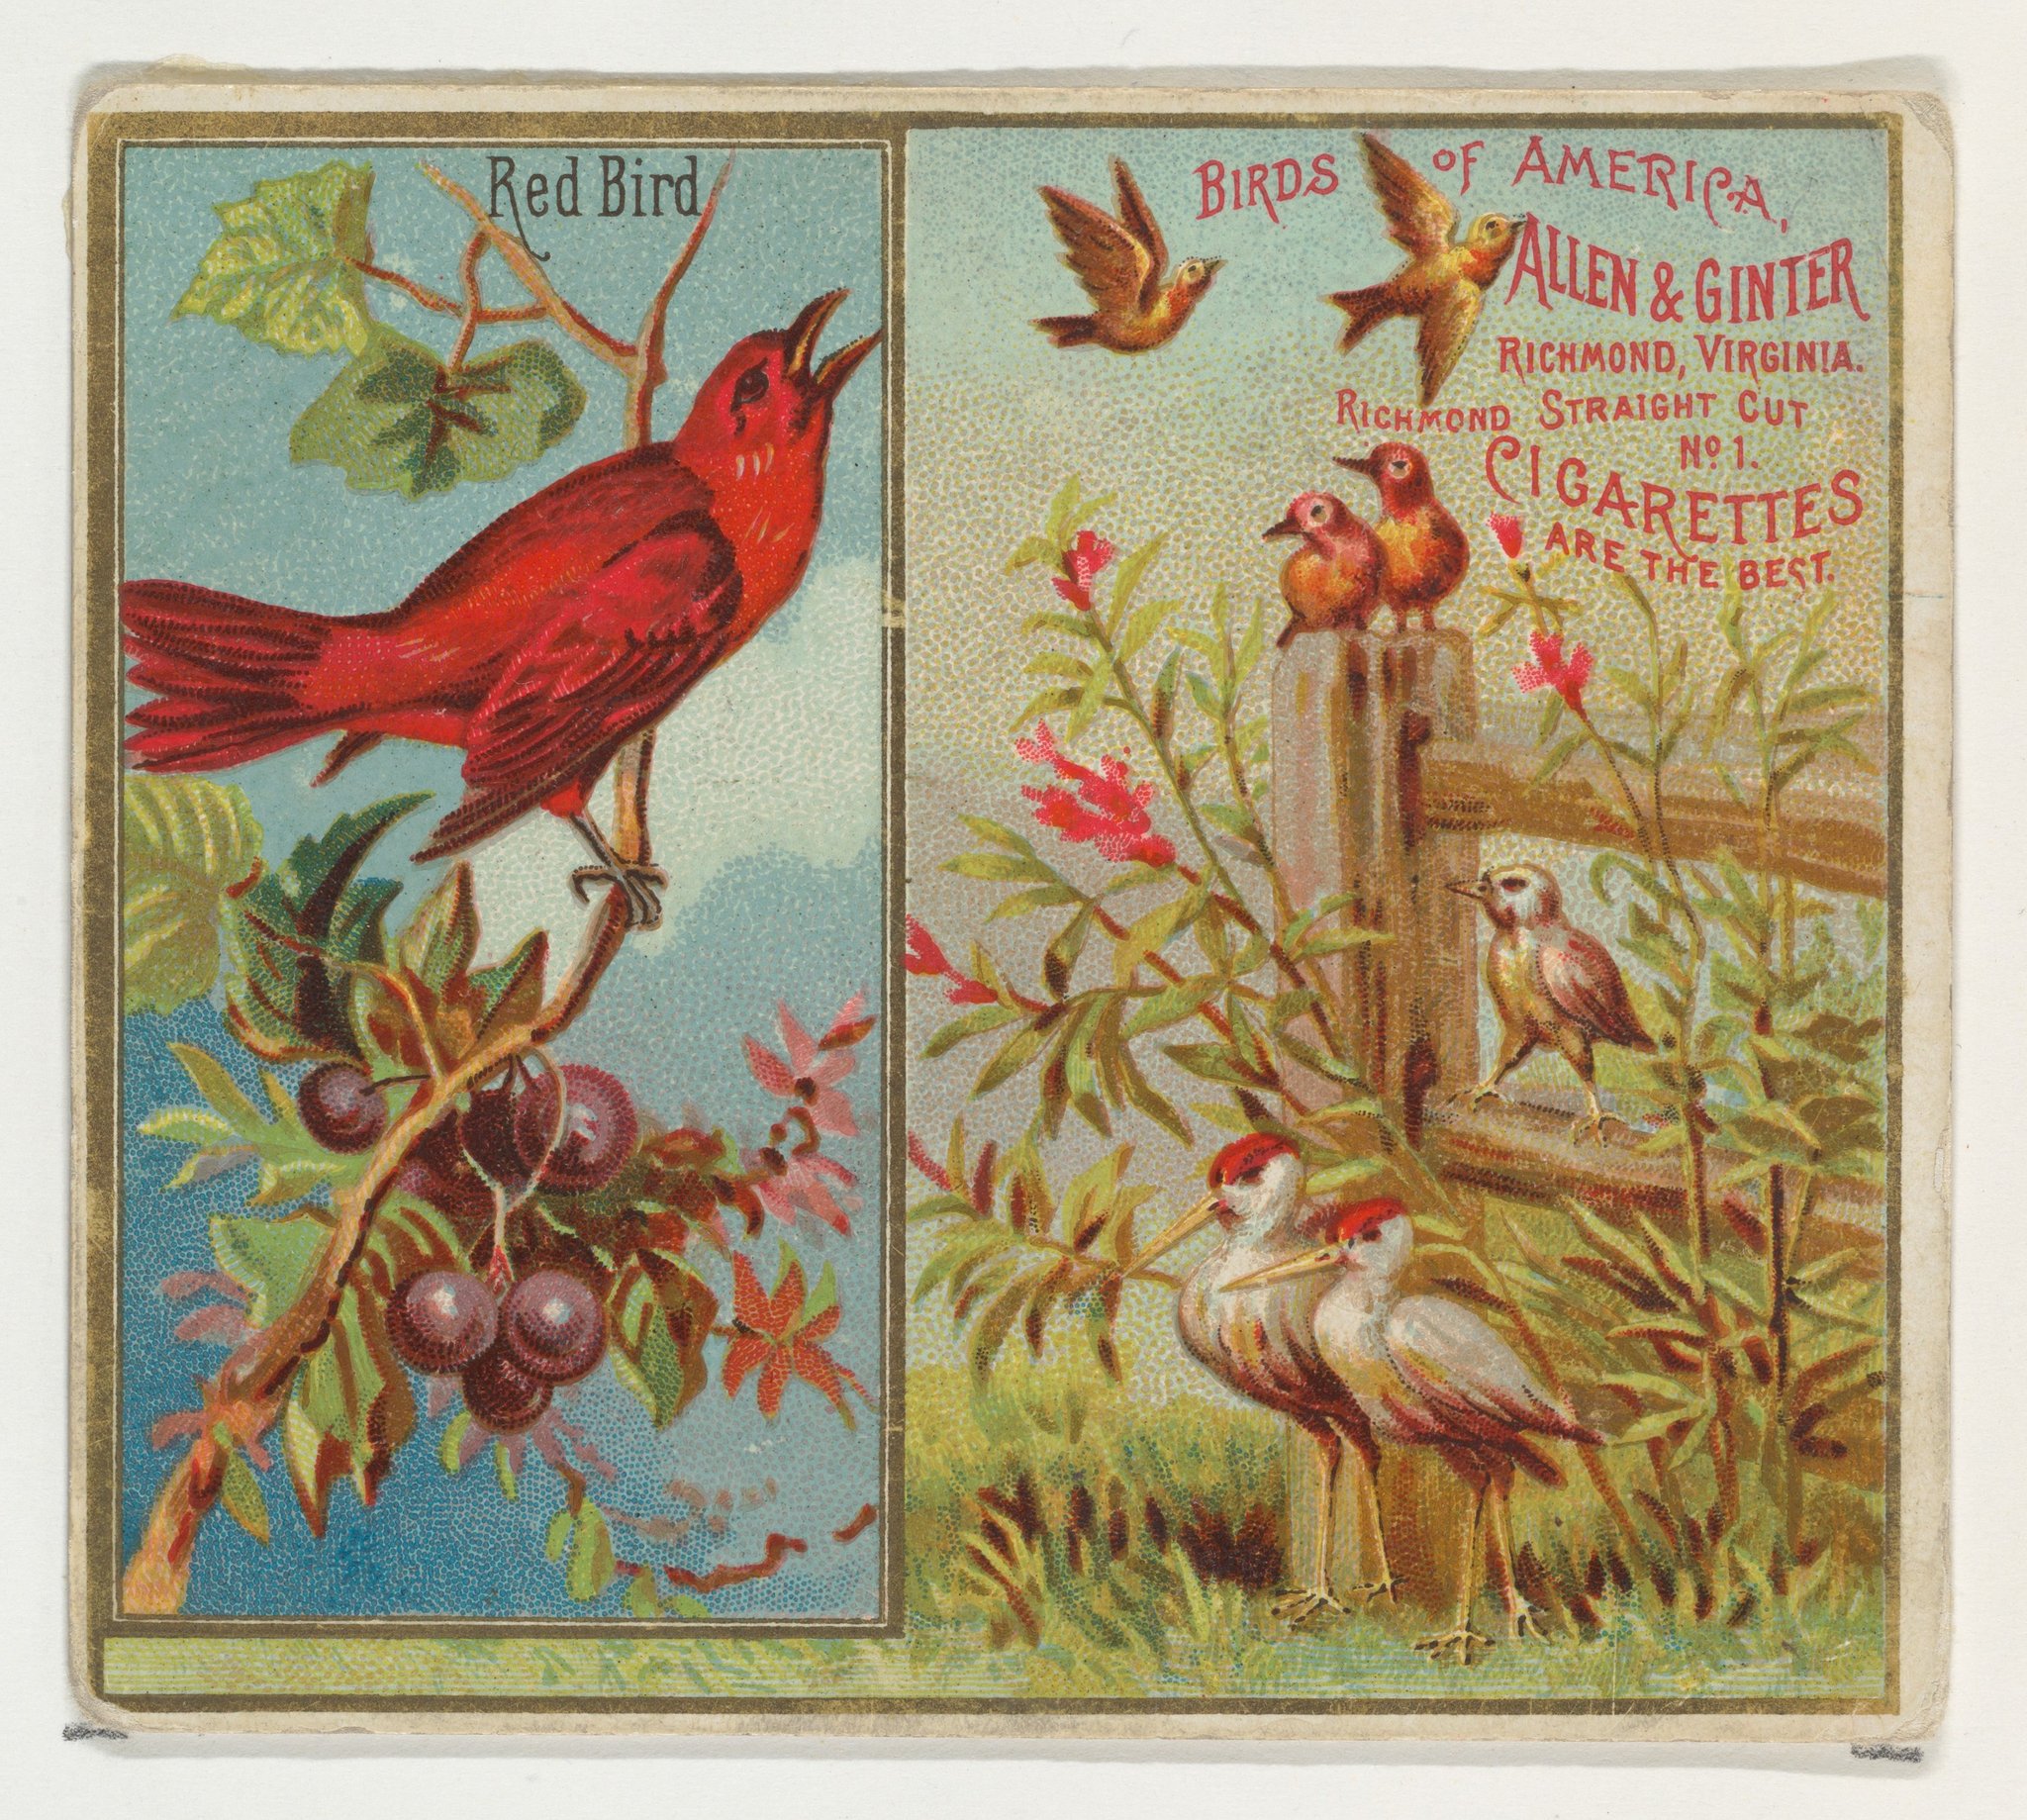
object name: print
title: Red Bird, from the Birds of America series (N37) for Allen & Ginter Cigarettes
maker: allen & ginter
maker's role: publisher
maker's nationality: american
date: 1888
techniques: color lithograph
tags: birds